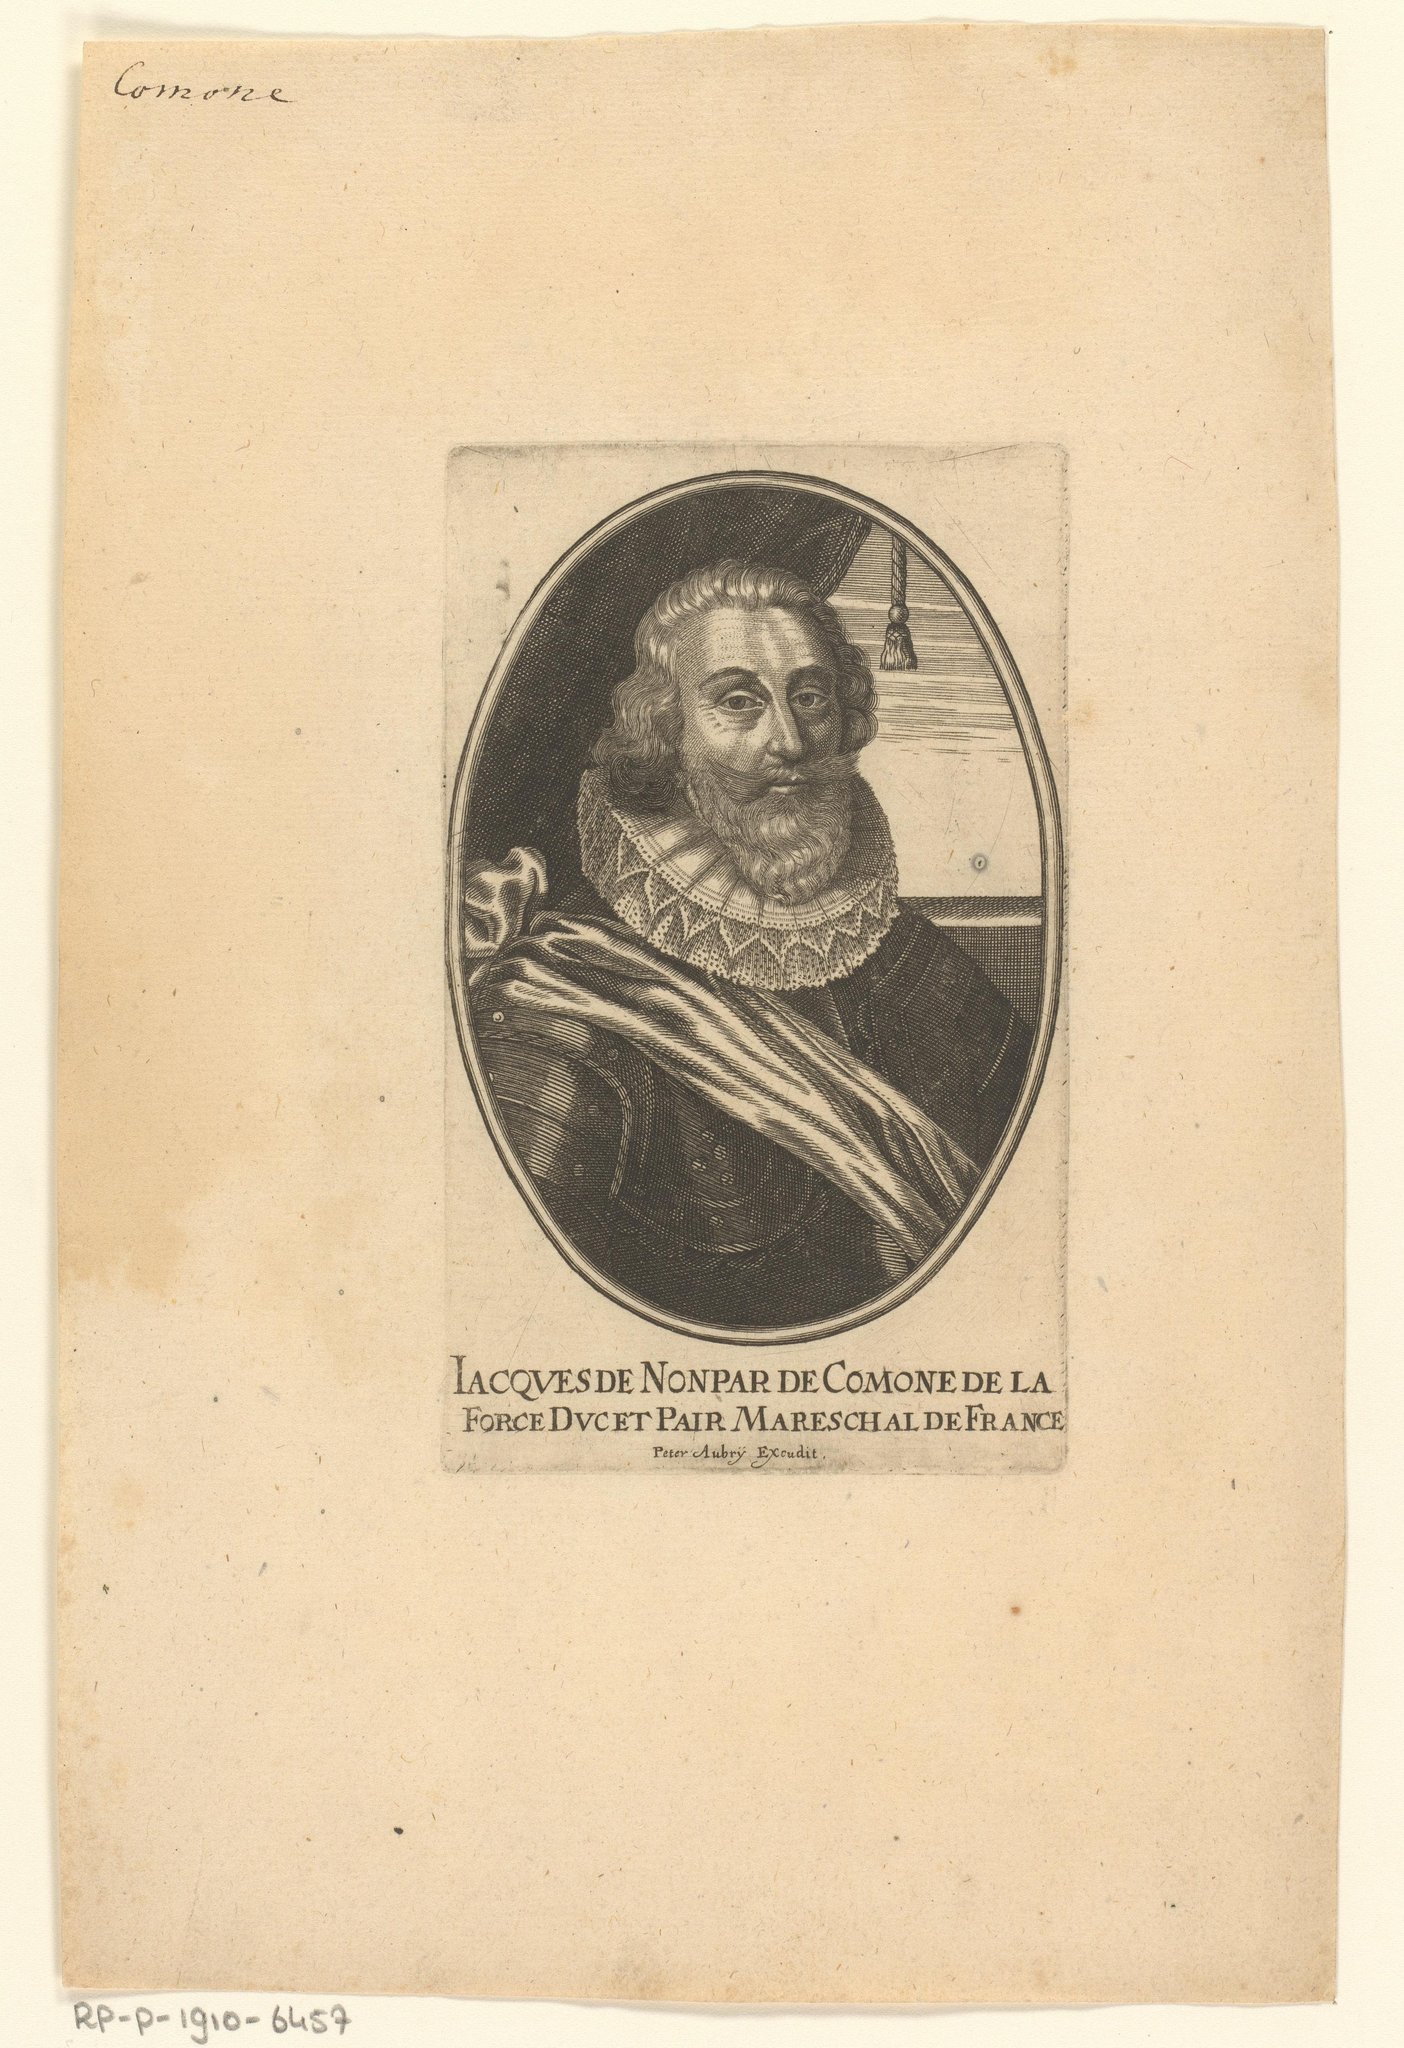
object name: print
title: Portret van Jacques-Nompar de Caumont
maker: Anonymous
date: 1637-1686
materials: paper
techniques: engraving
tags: historical persons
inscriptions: collector's mark: Lugt 2228, inscription: ‘Comone’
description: Met tweeregelig onderschrift in het Frans.